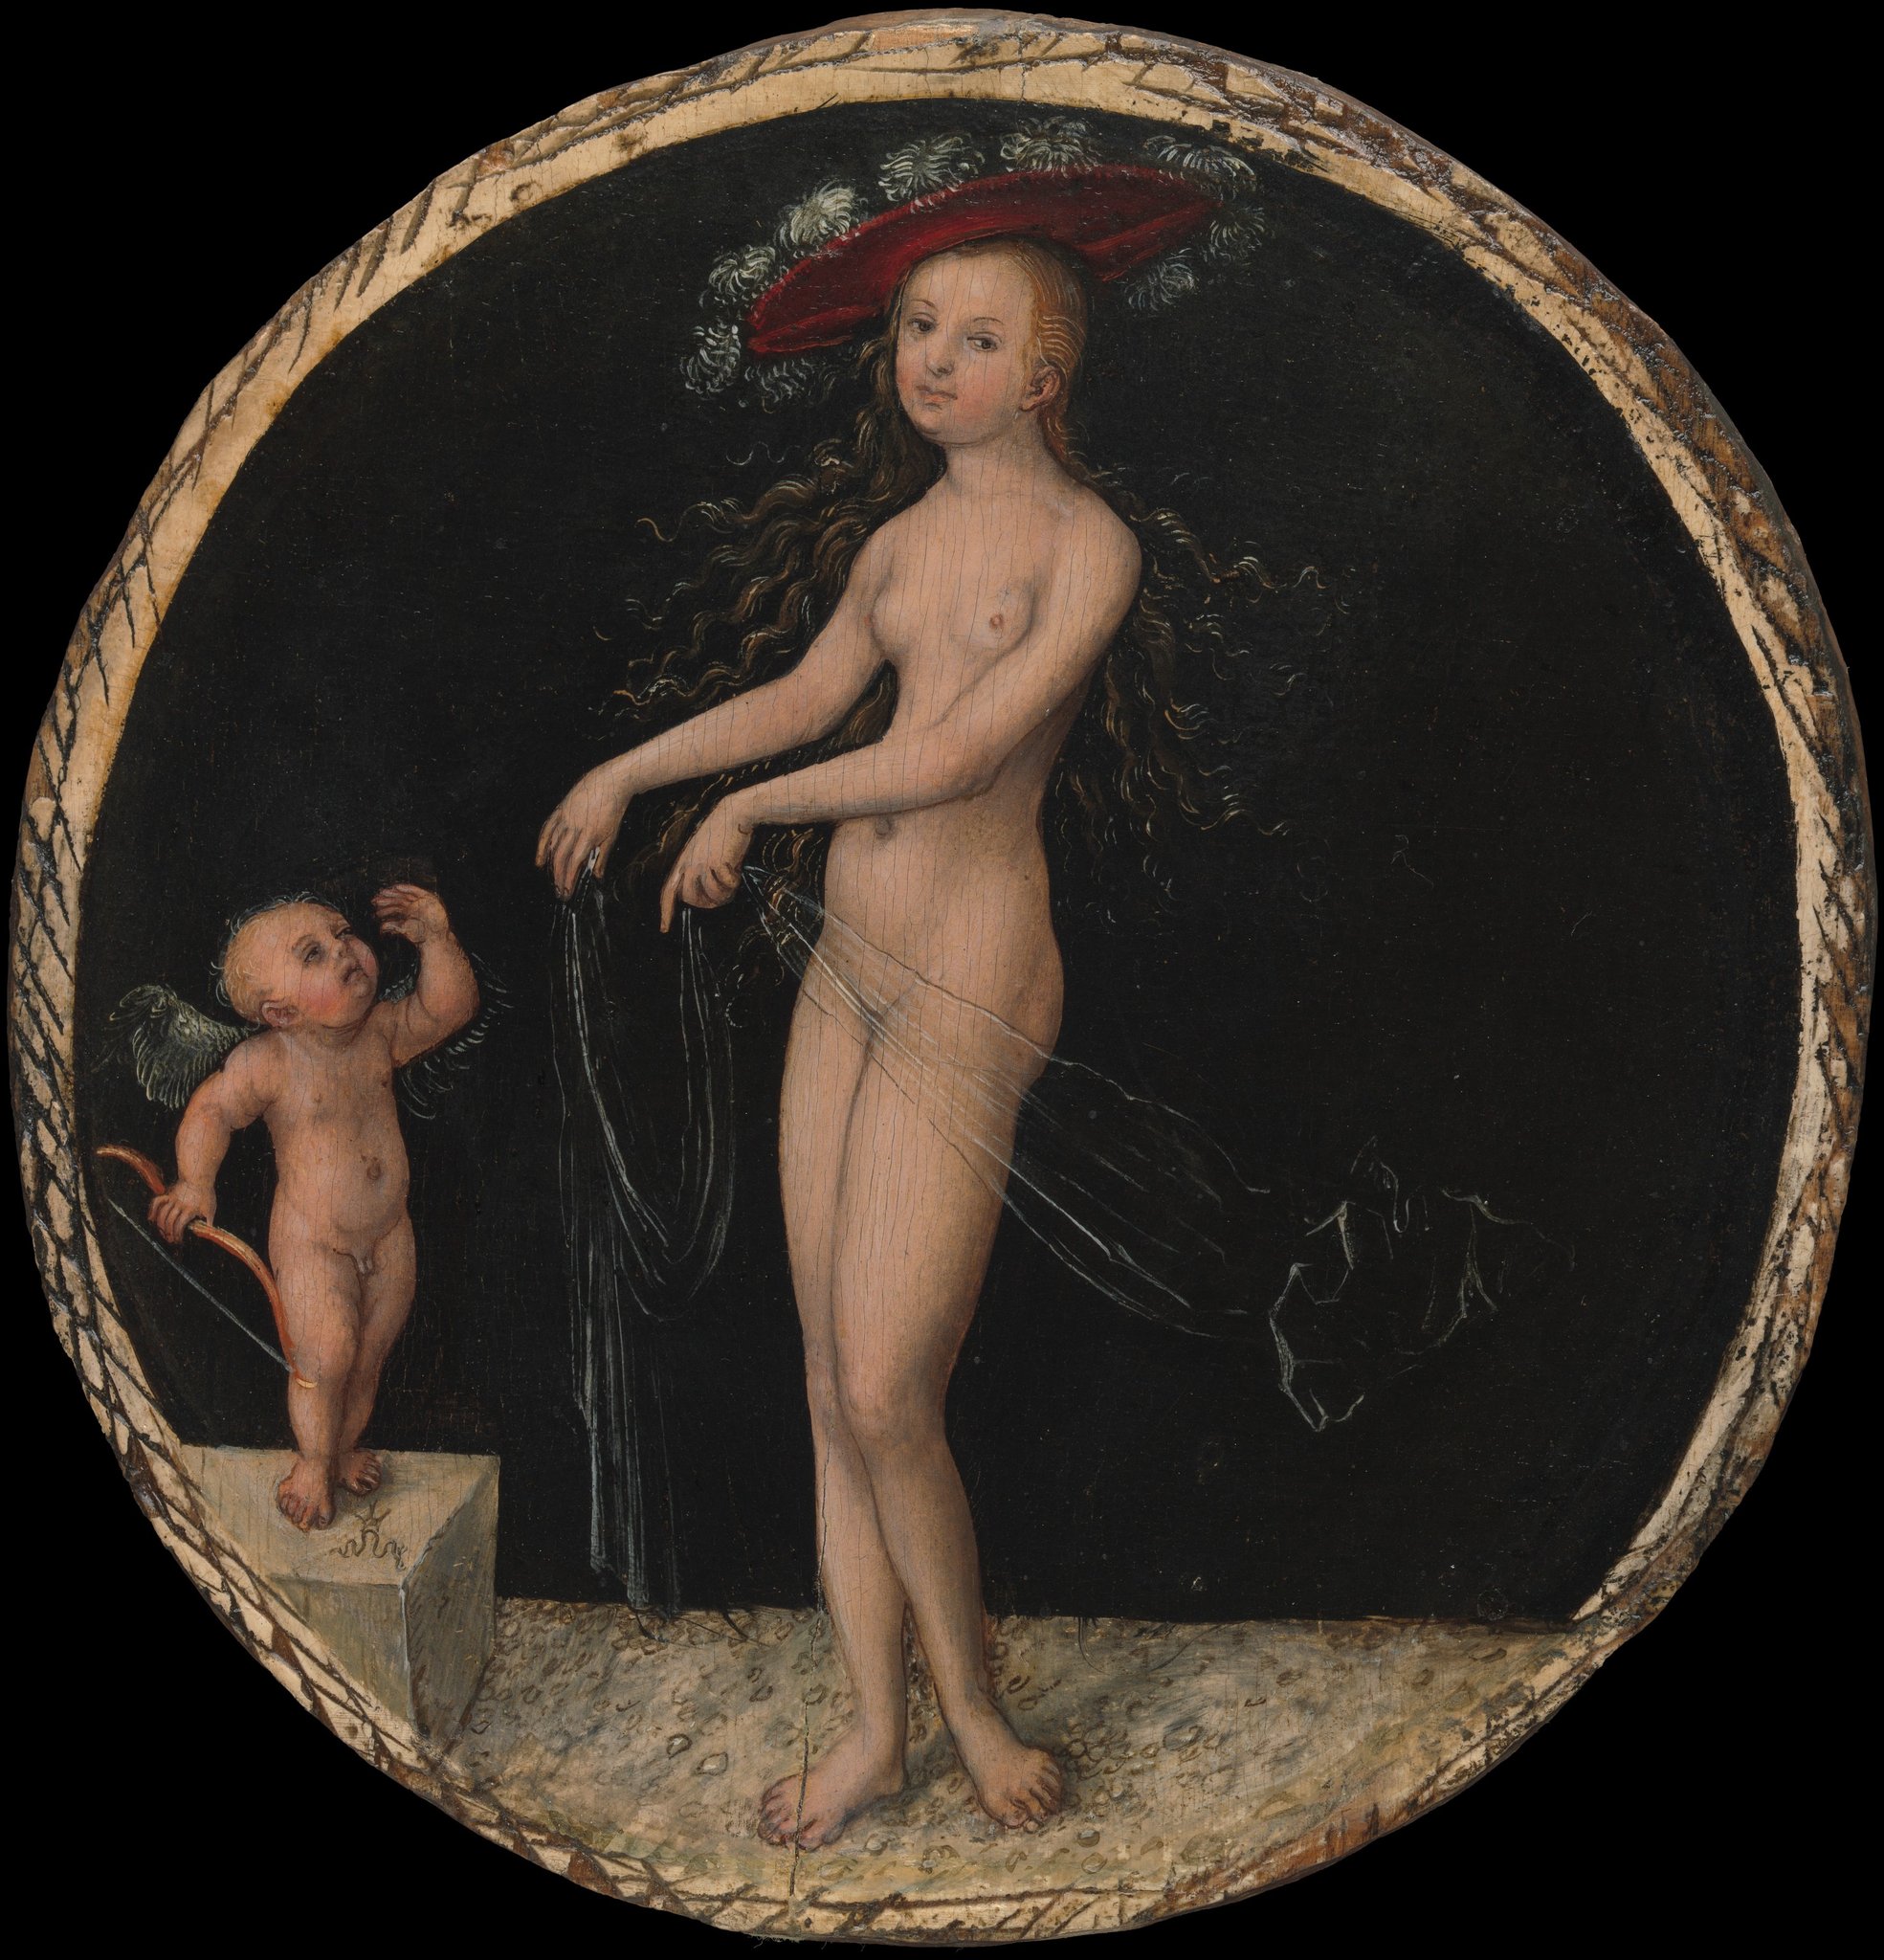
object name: painting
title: Venus and Cupid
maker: lucas cranach the elder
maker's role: artist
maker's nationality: german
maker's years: 1472-1553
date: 1525-1527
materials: oil, wood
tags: female nudes,cupid,venus